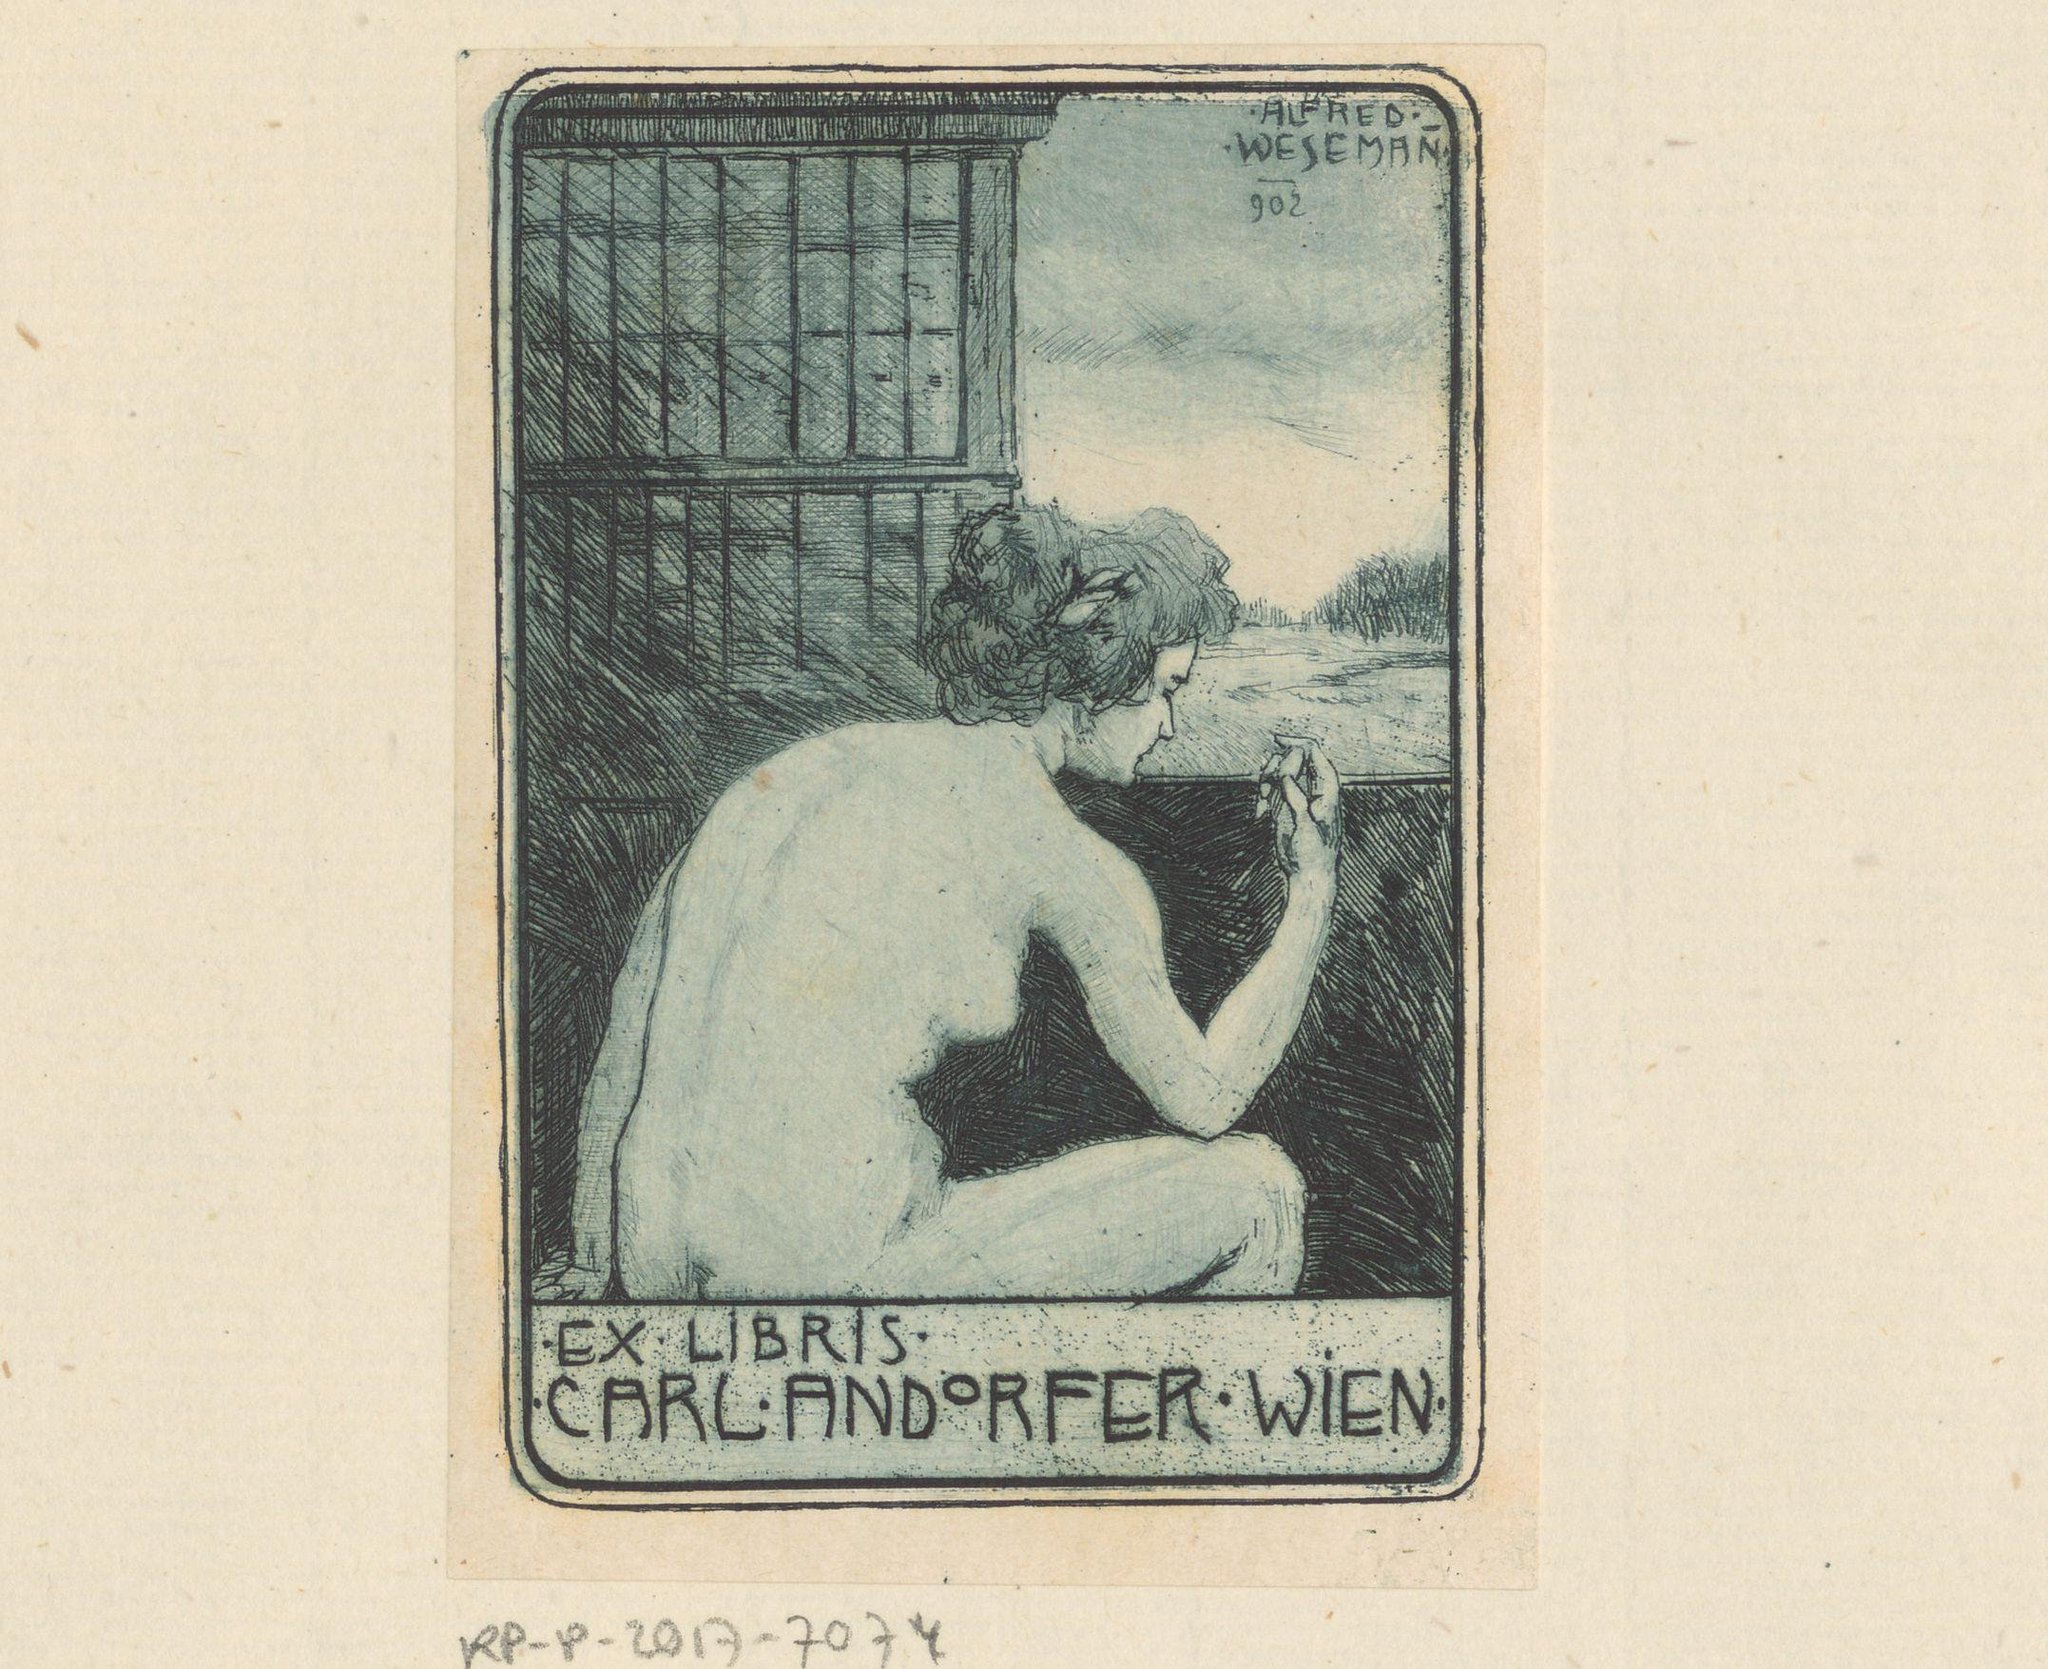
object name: bookplate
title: Ex libris van Carl Andorfer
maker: alfred weseman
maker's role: print maker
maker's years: 1874-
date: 1902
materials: paper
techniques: etching, intaglio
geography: austria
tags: vienna, bookshelves, woman (showing herself) undressed, quasi-nude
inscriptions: date